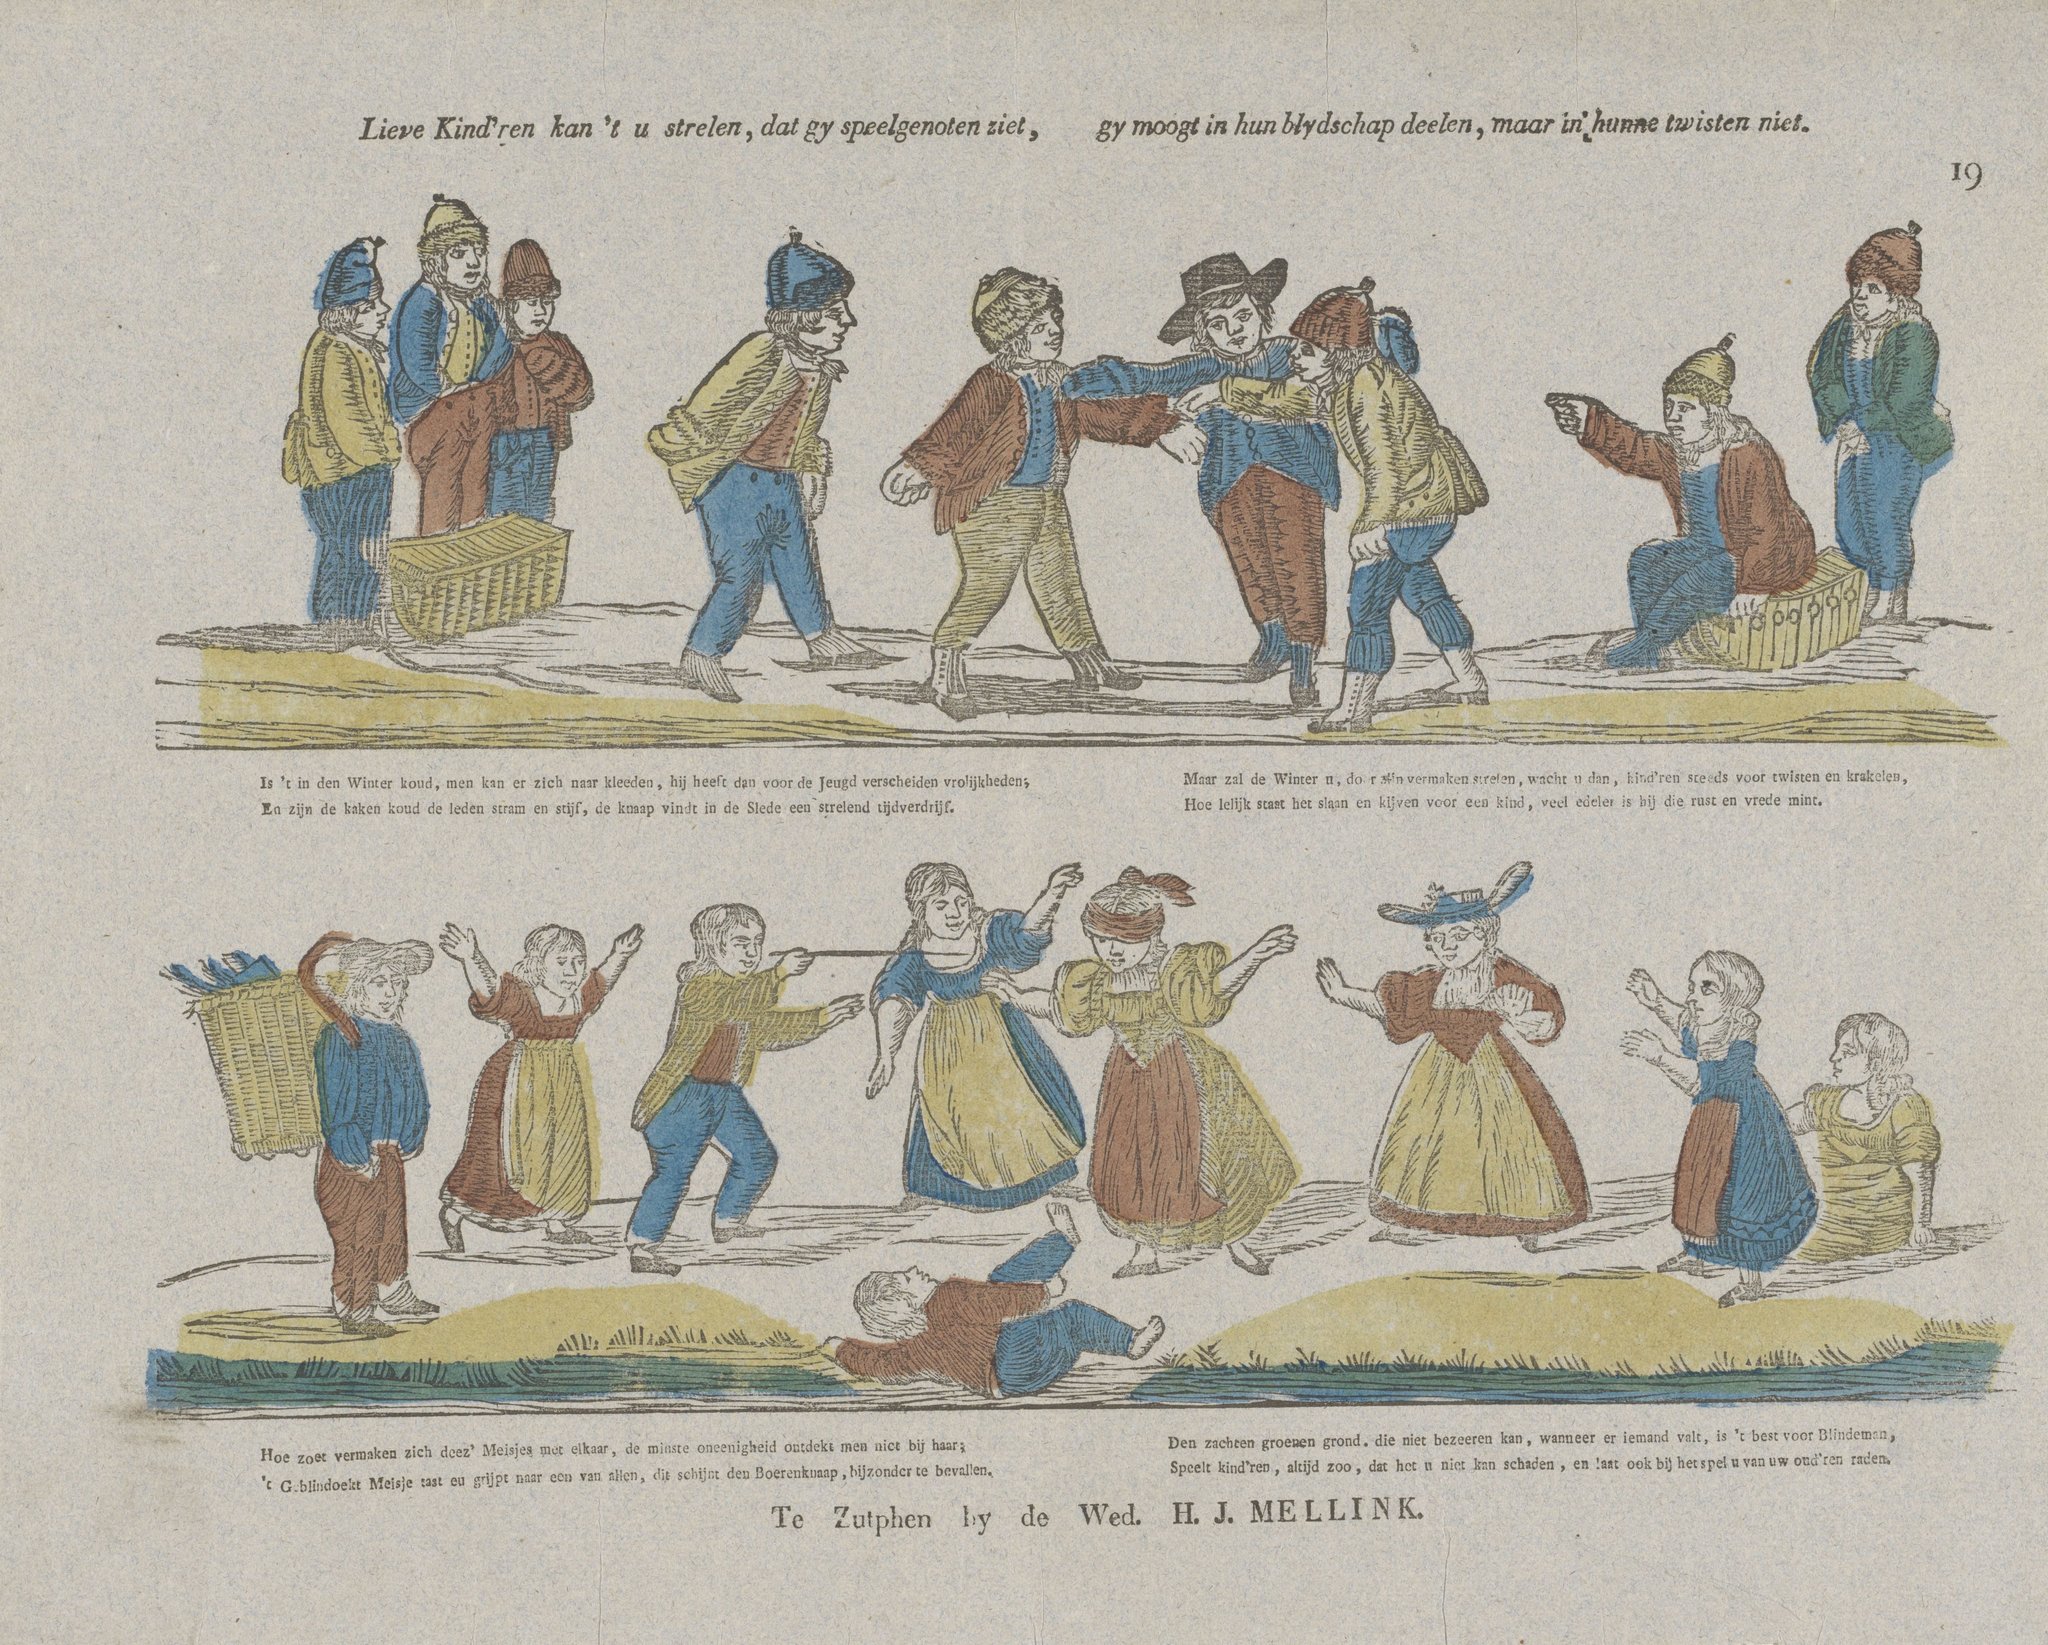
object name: print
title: Lieve kind'ren kan 't u strelen, dat gy speelgenoten ziet, / gy moogt in hun blydschap deelen, maar in hunne twisten niet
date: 1700-1899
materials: paper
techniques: colour, letterpress printing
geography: netherlands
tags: children's games and plays, blind-man's buff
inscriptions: collector's mark: Lugt 2760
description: Blad met 2 voorstellingen van spelende kinderen. Onder elke voorstelling een vierregelig vers in twee kolommen. Genummerd rechtsboven: 19.